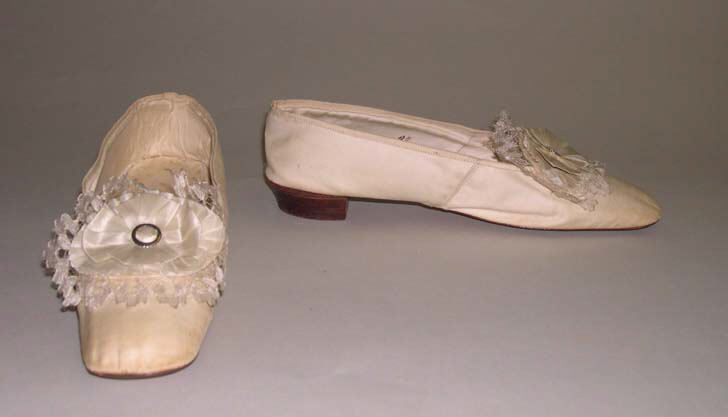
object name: shoe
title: Shoes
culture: american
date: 1860-1869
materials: cotton, leather